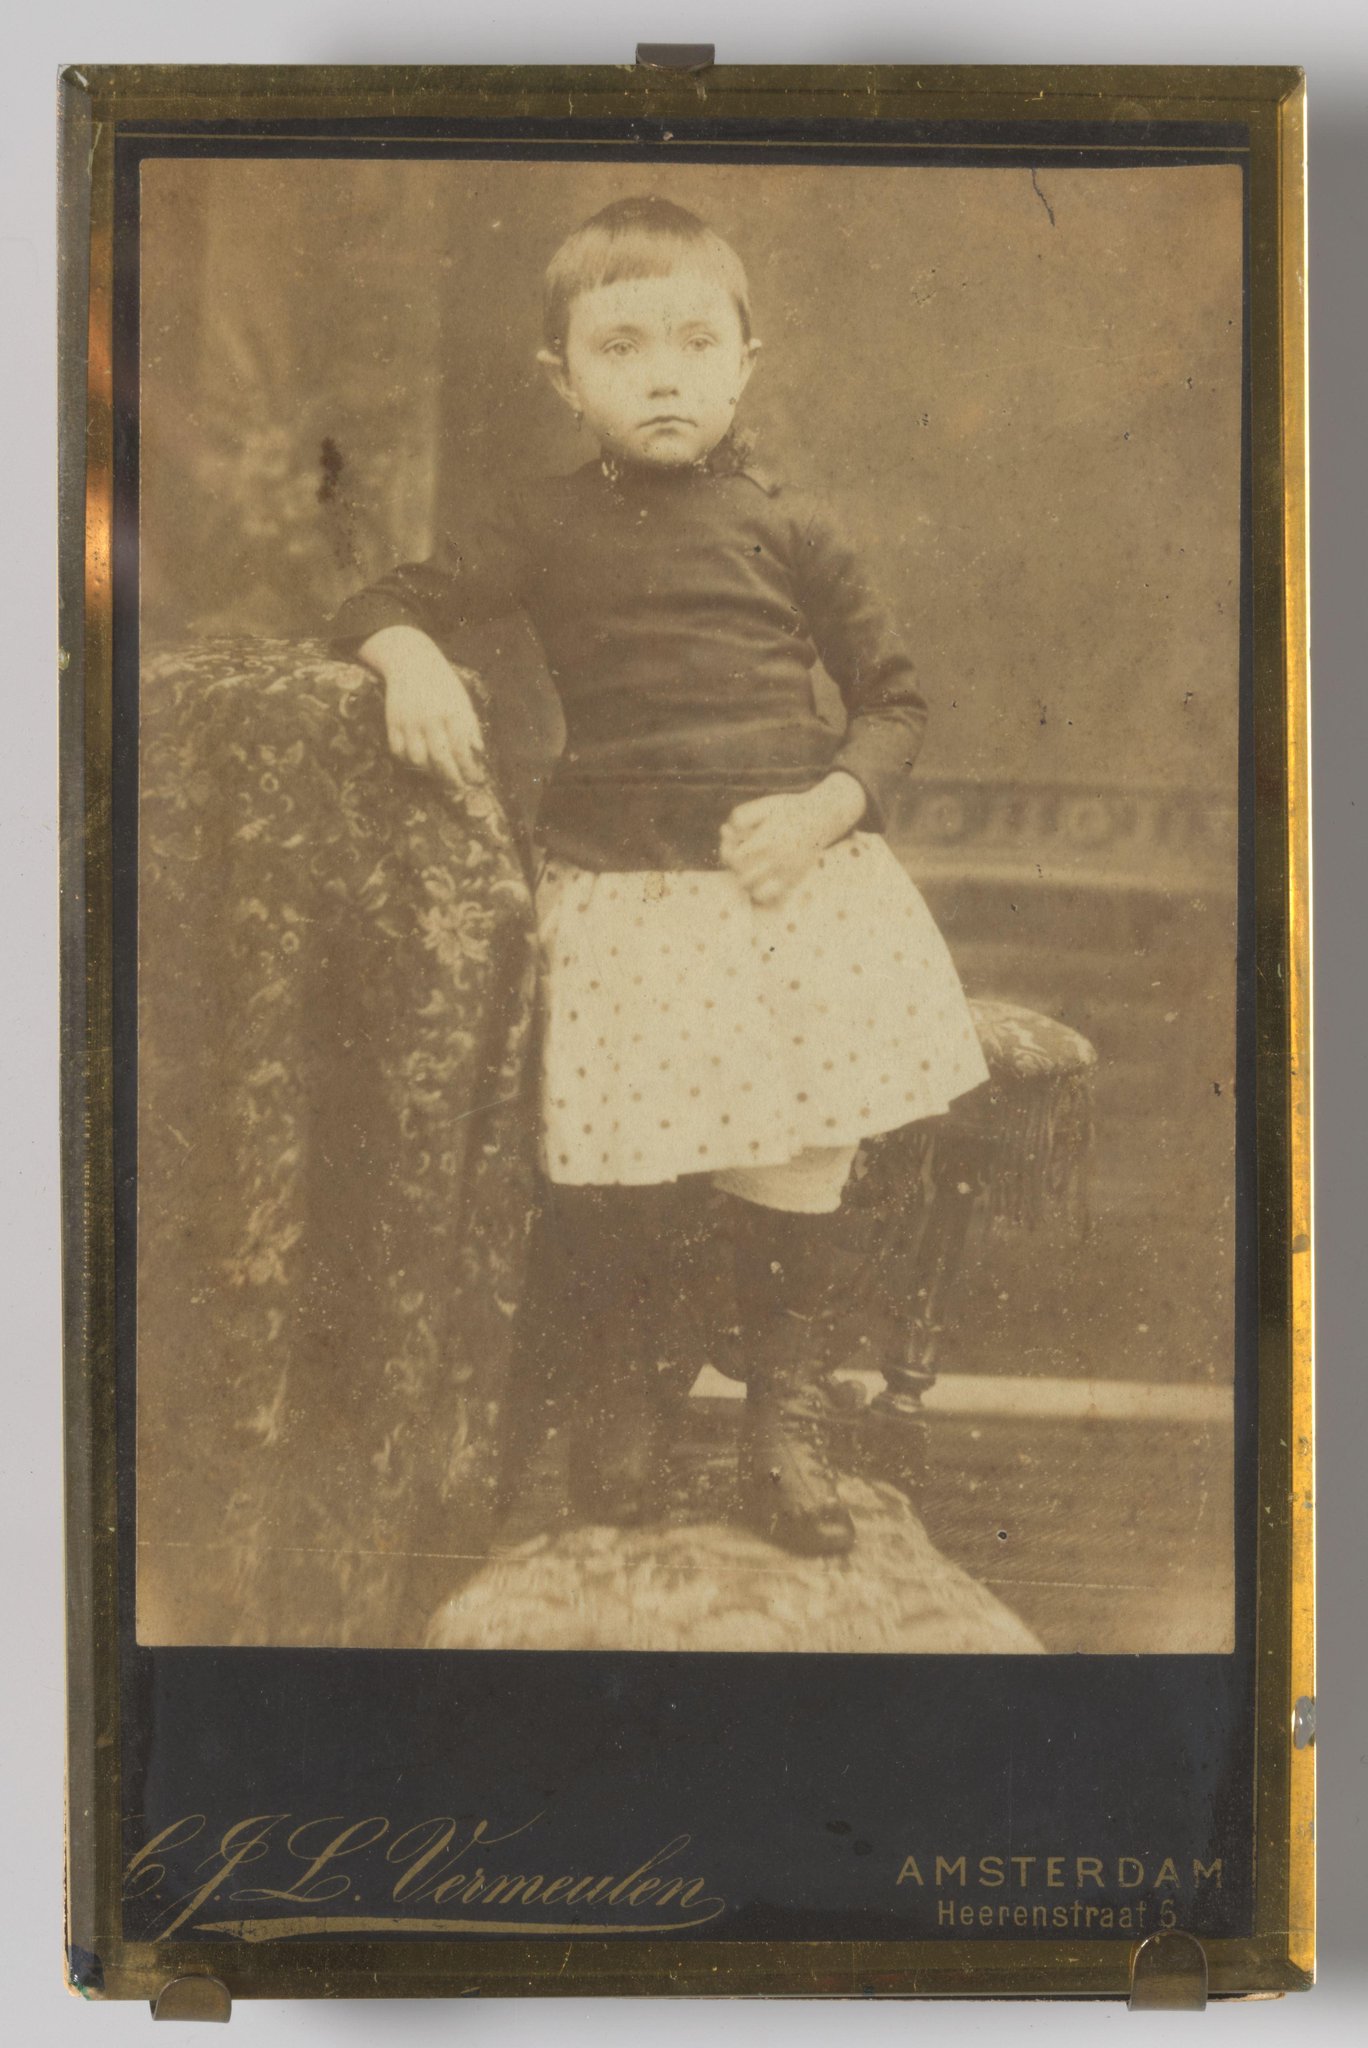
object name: cabinet photograph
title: Portret van een onbekend meisje met rok op stoel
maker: cornelis johannes lodewicus vermeulen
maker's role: fotograaf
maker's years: 1861-1936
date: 1888-1896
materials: glass, metal, paper, wood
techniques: albumen print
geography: amsterdam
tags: girl (child between toddler and youth), anonymous historical person portrayed, amsterdam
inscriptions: address: ‘AMSTERDAM/ Heerenstraat 5’